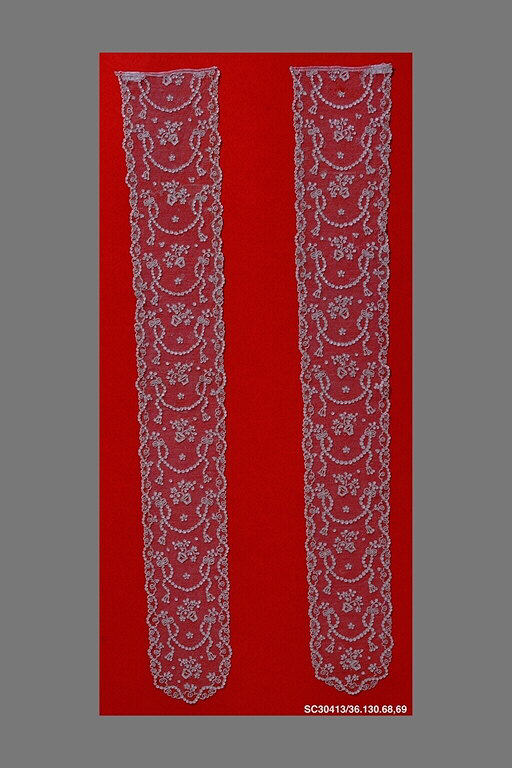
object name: lappet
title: Lappets (one of a pair)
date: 1701-1800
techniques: lace